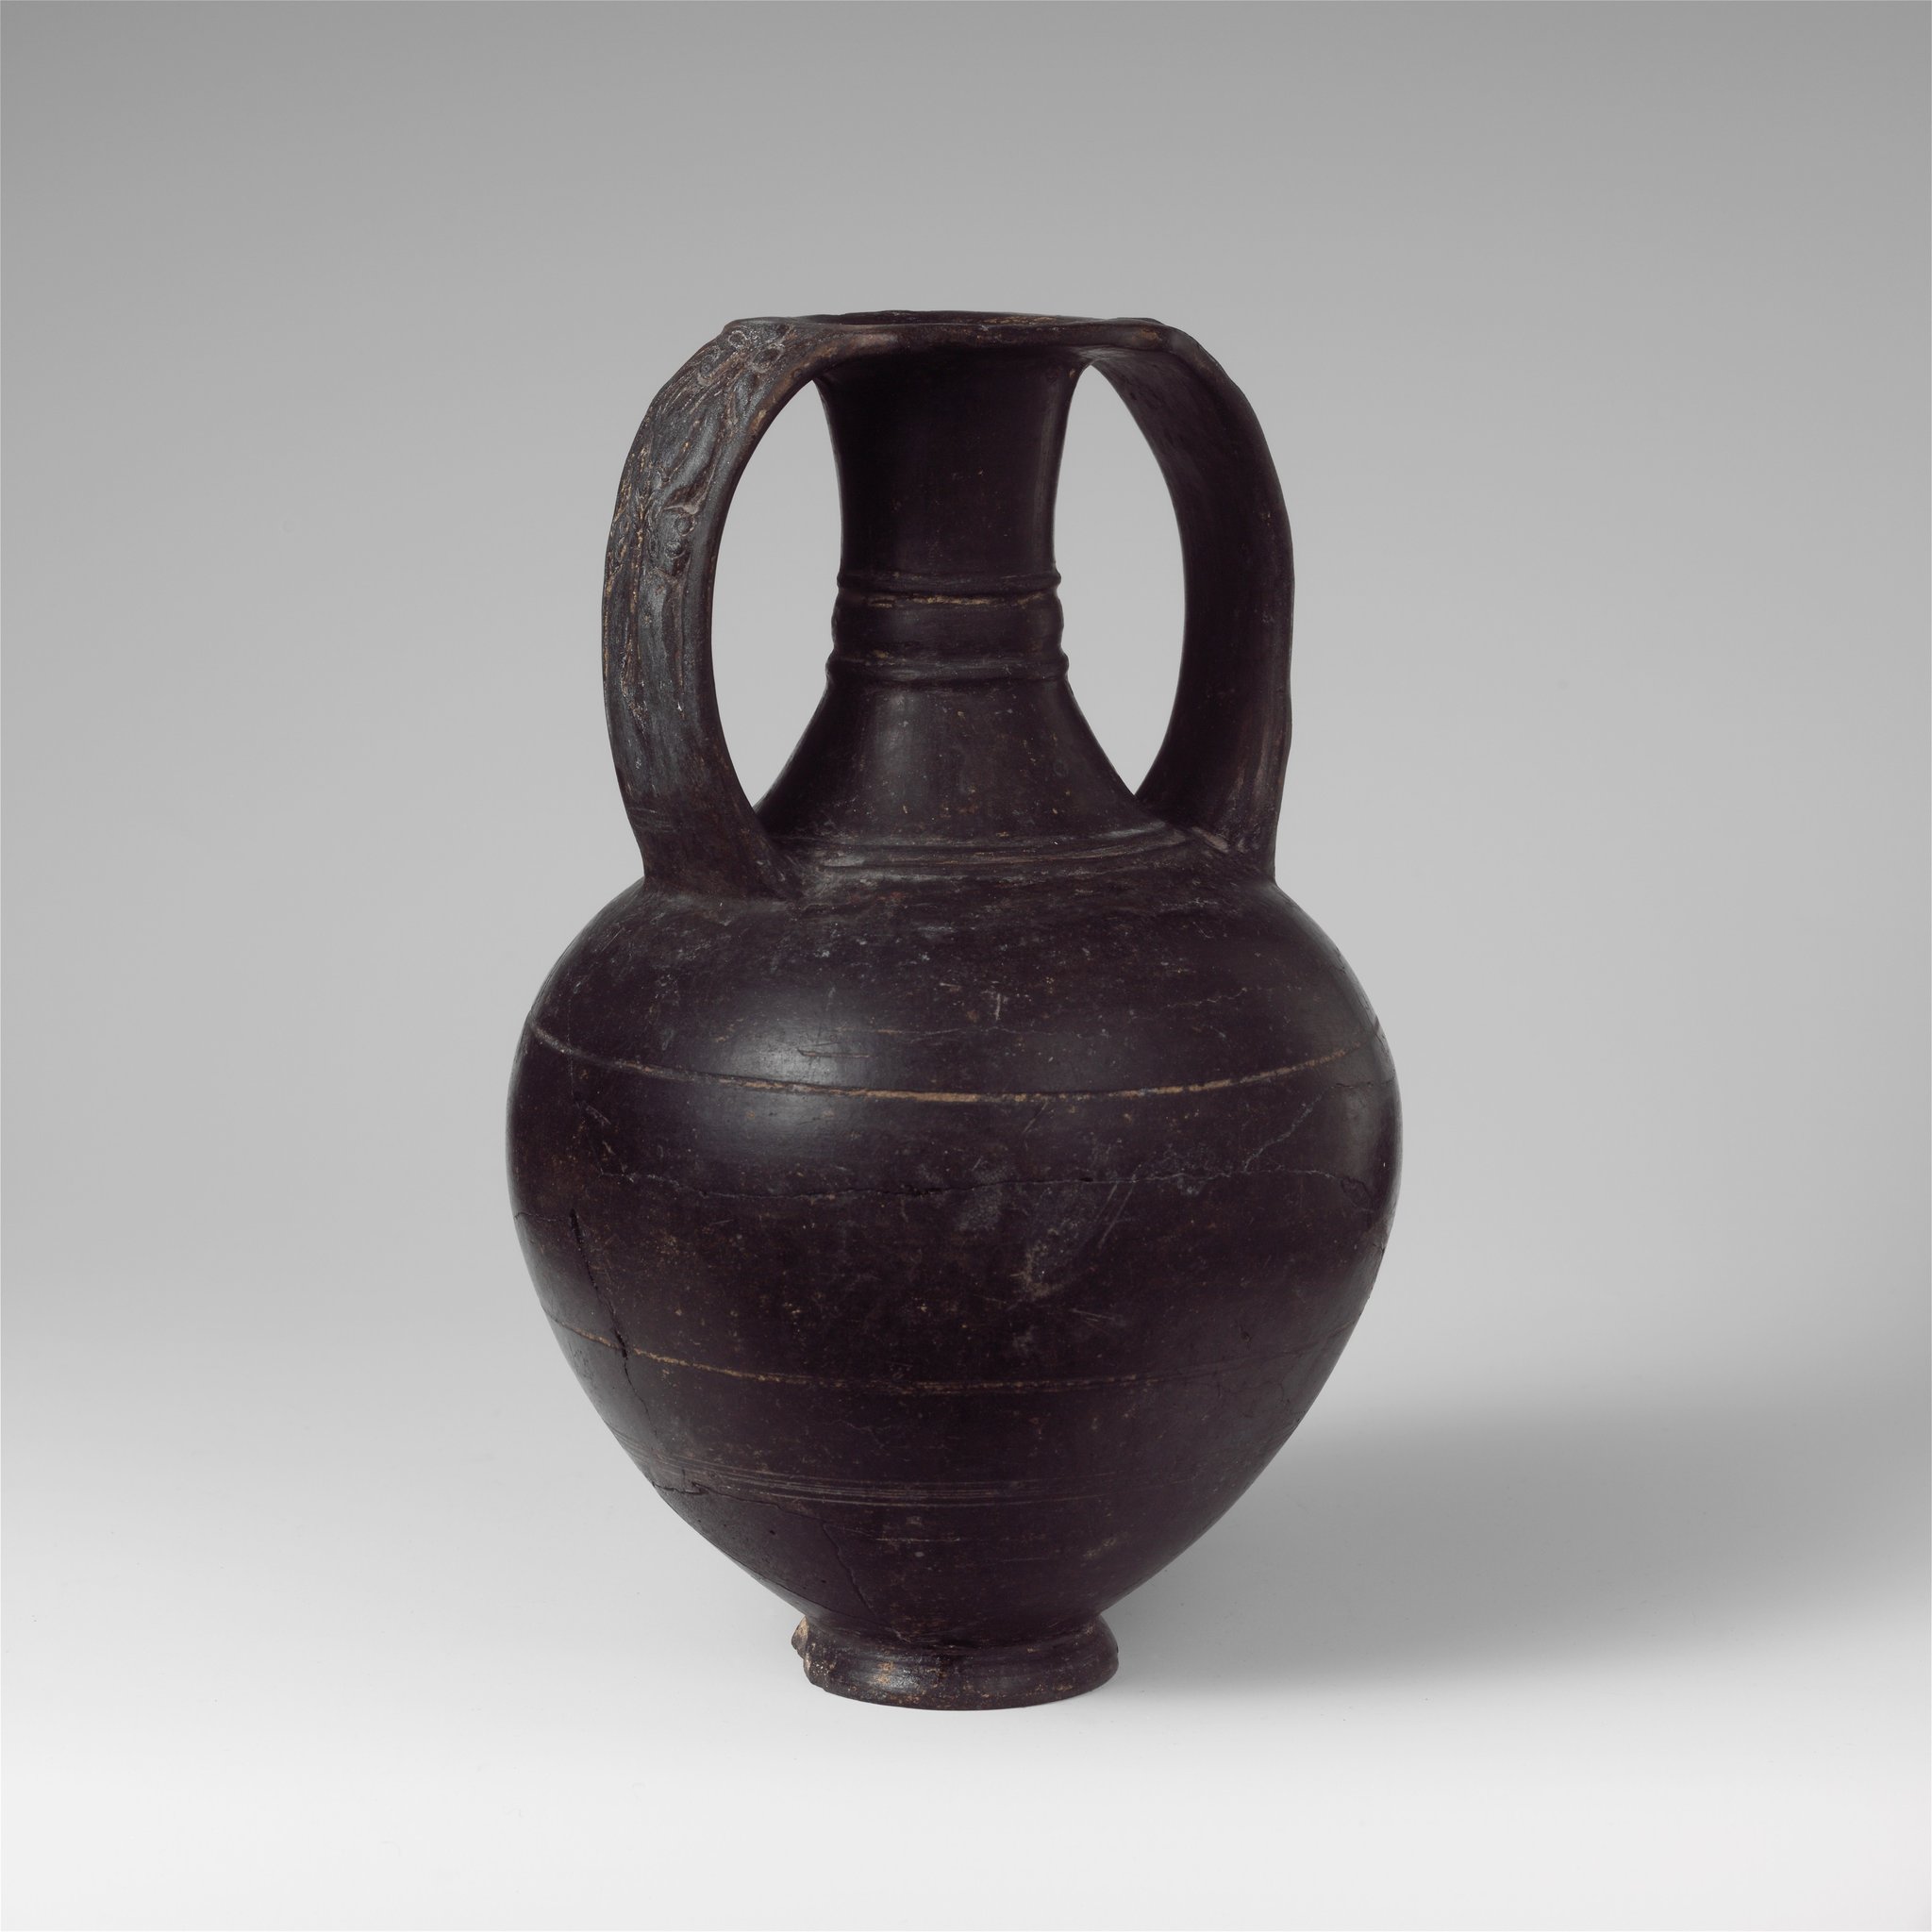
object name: nicosthenic neck amphora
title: Terracotta Nicosthenic neck-amphora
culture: etruscan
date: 600-501 BCE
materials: terracotta